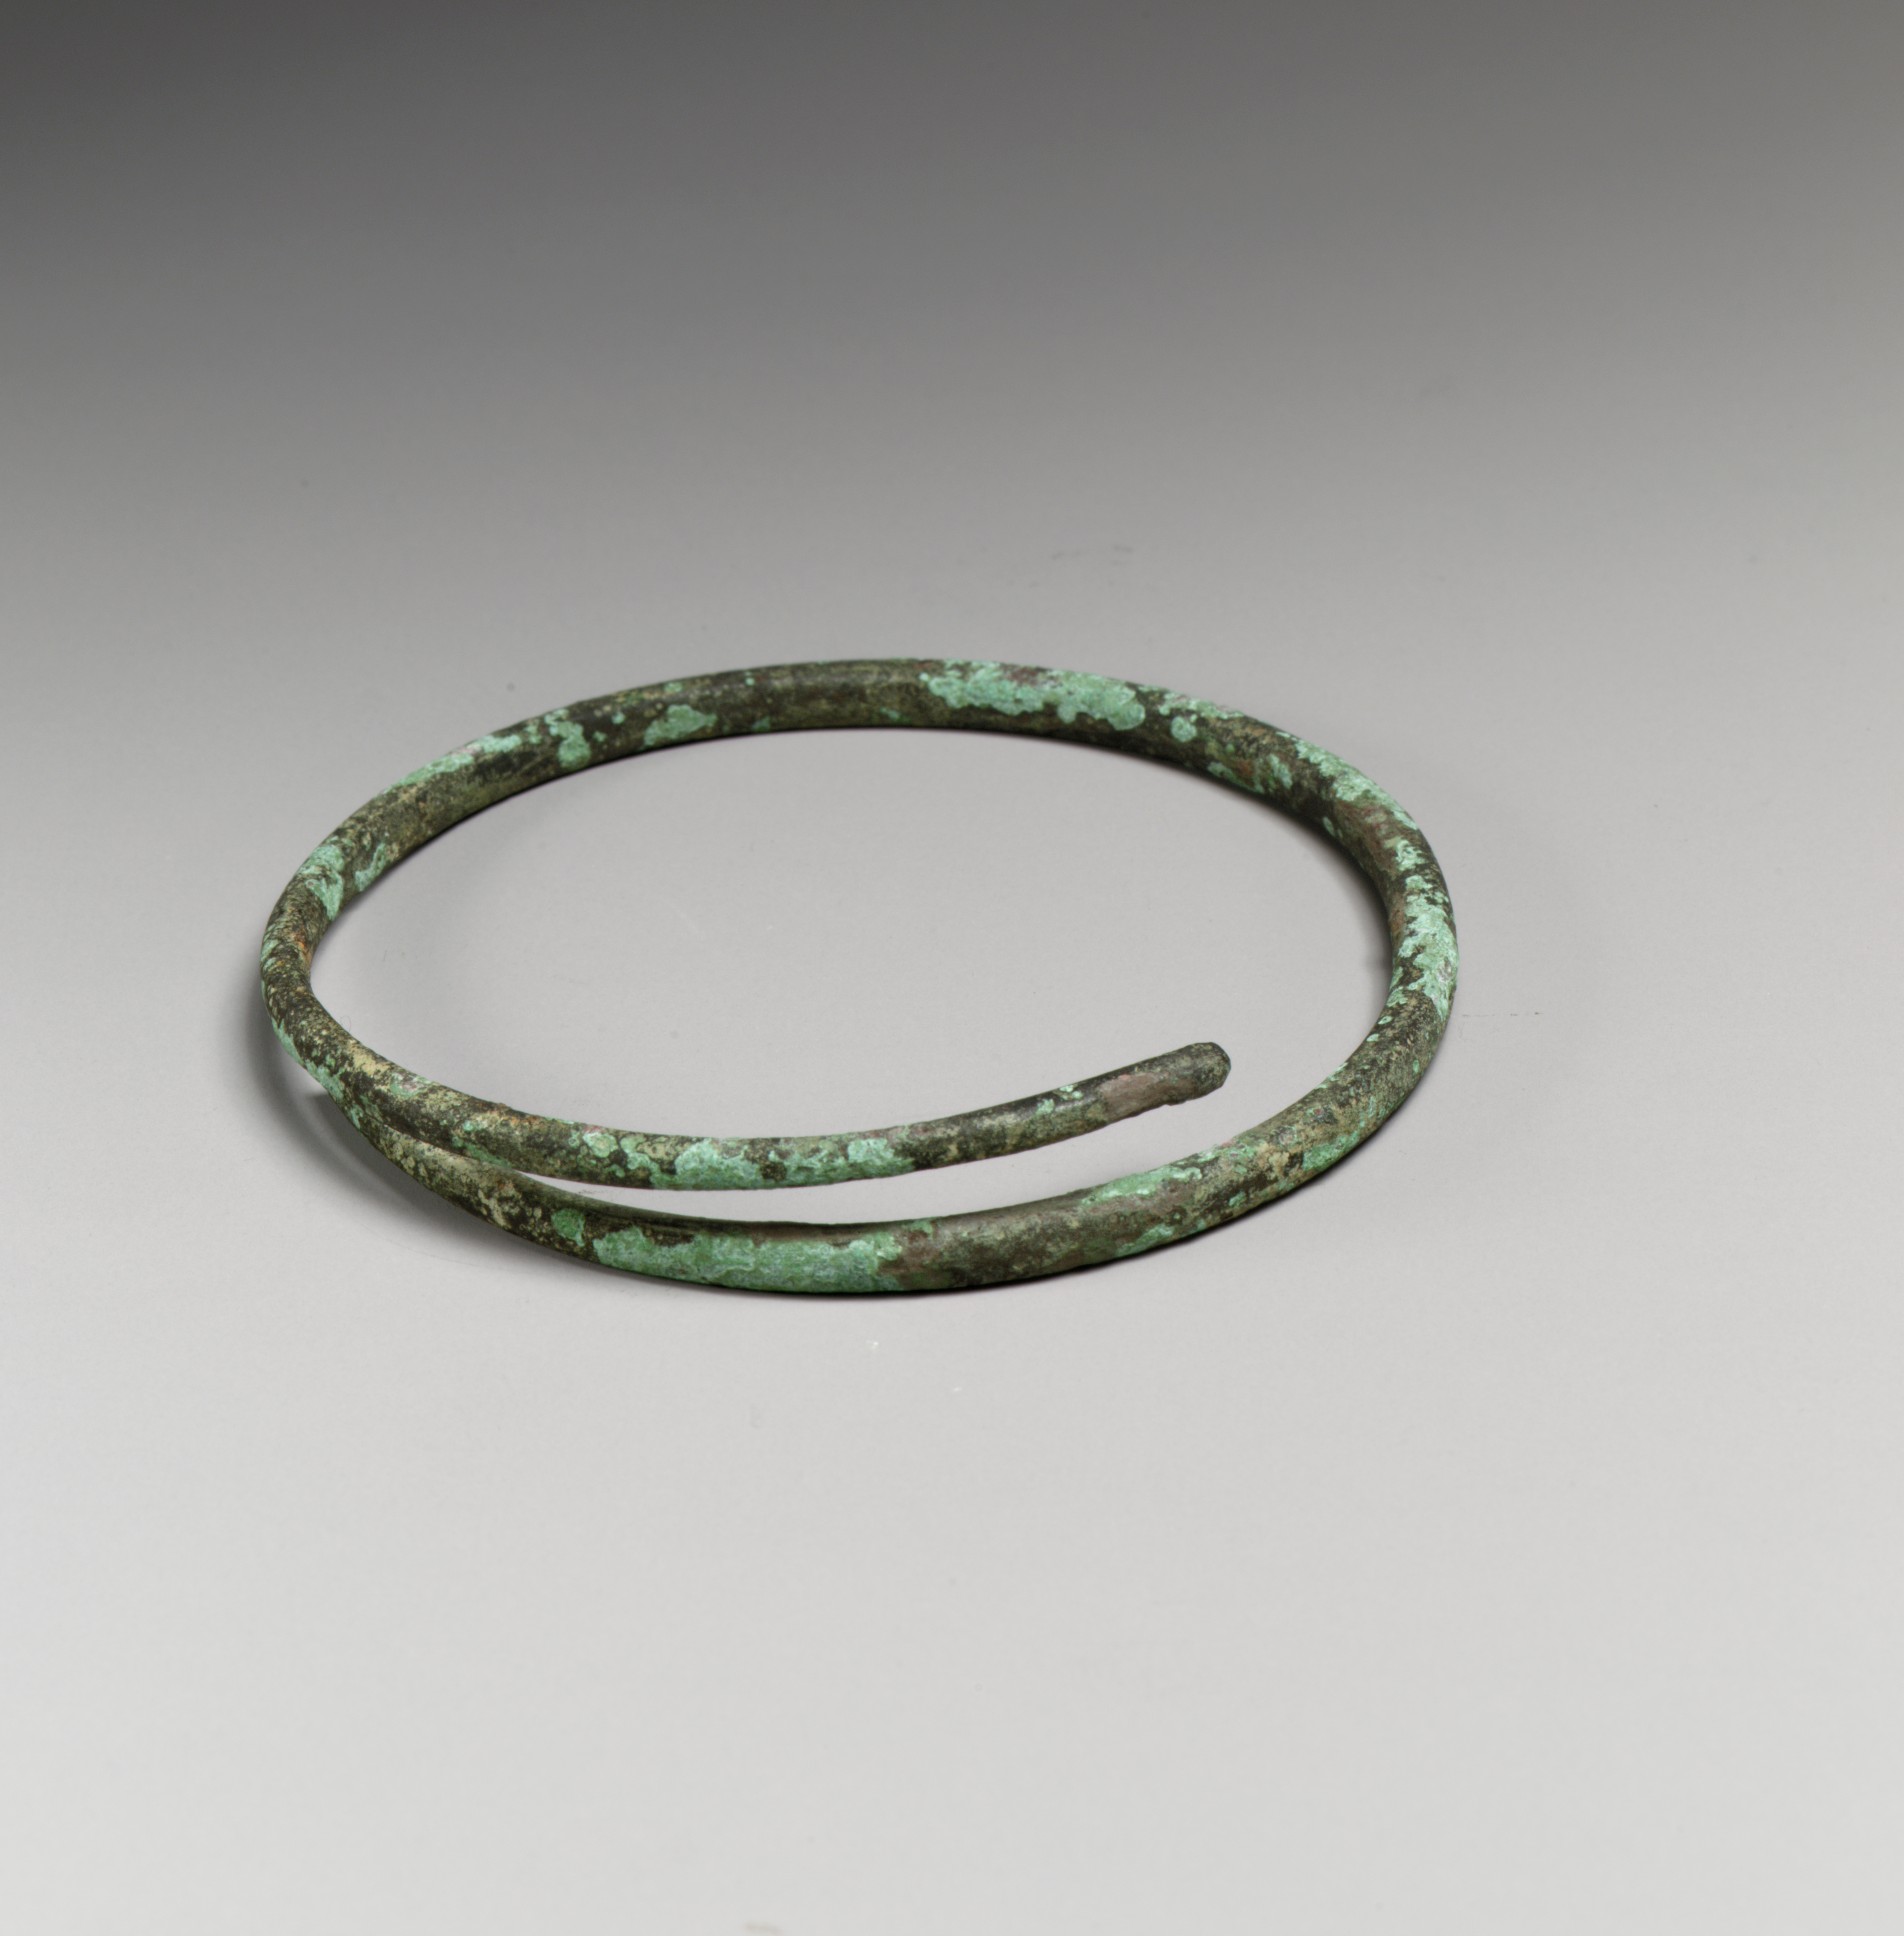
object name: bracelet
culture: etruscan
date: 900-100 BCE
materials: bronze